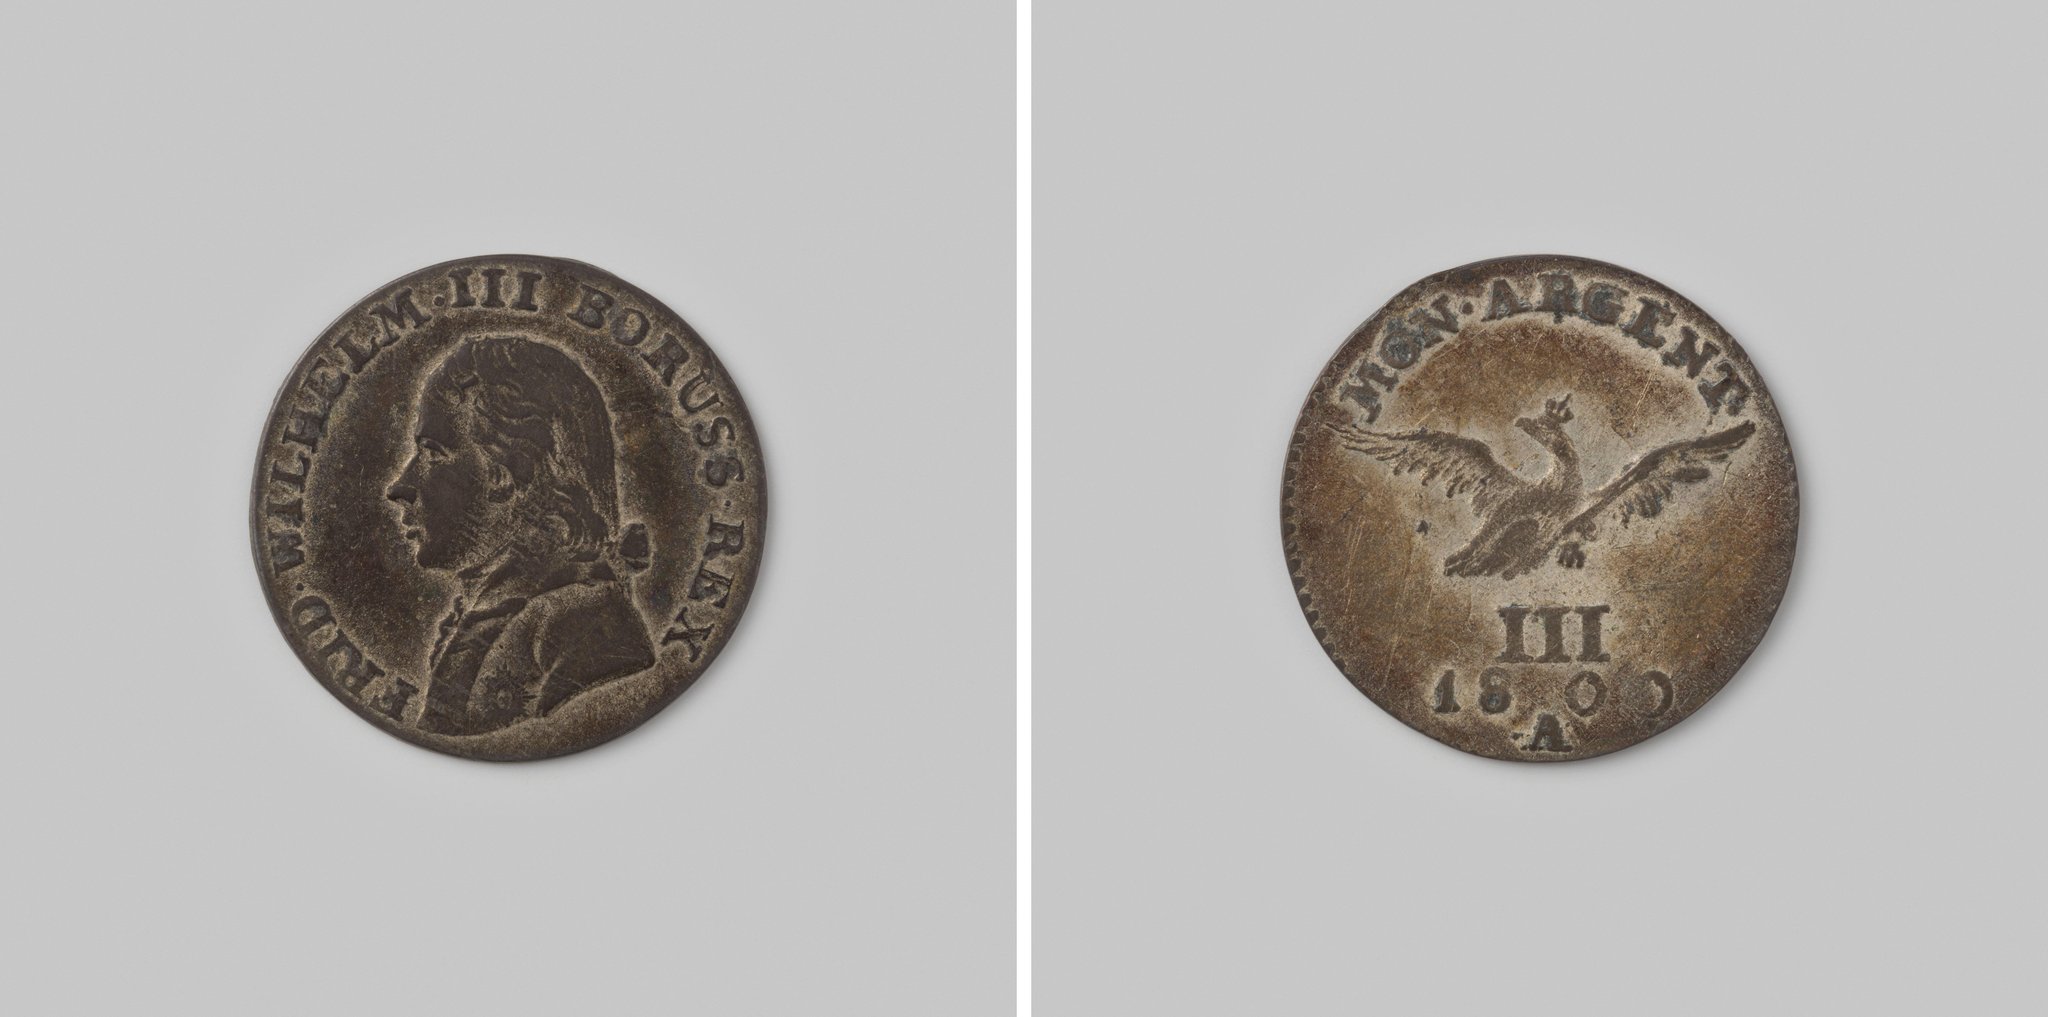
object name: coin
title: 3 Kreuzer uit Silezië als provincie van Pruisen van Friedrich Wilhelm III, 1800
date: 1800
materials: silver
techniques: striking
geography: berlin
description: Zilveren munt. Voorzijde: borstbeeld van de koning naar links. Keerzijde: vliegende gekroonde adelaar. Daaronder waarde-aanduiding, waaronder jaartal. Daaronder letter A. Gladde rand.